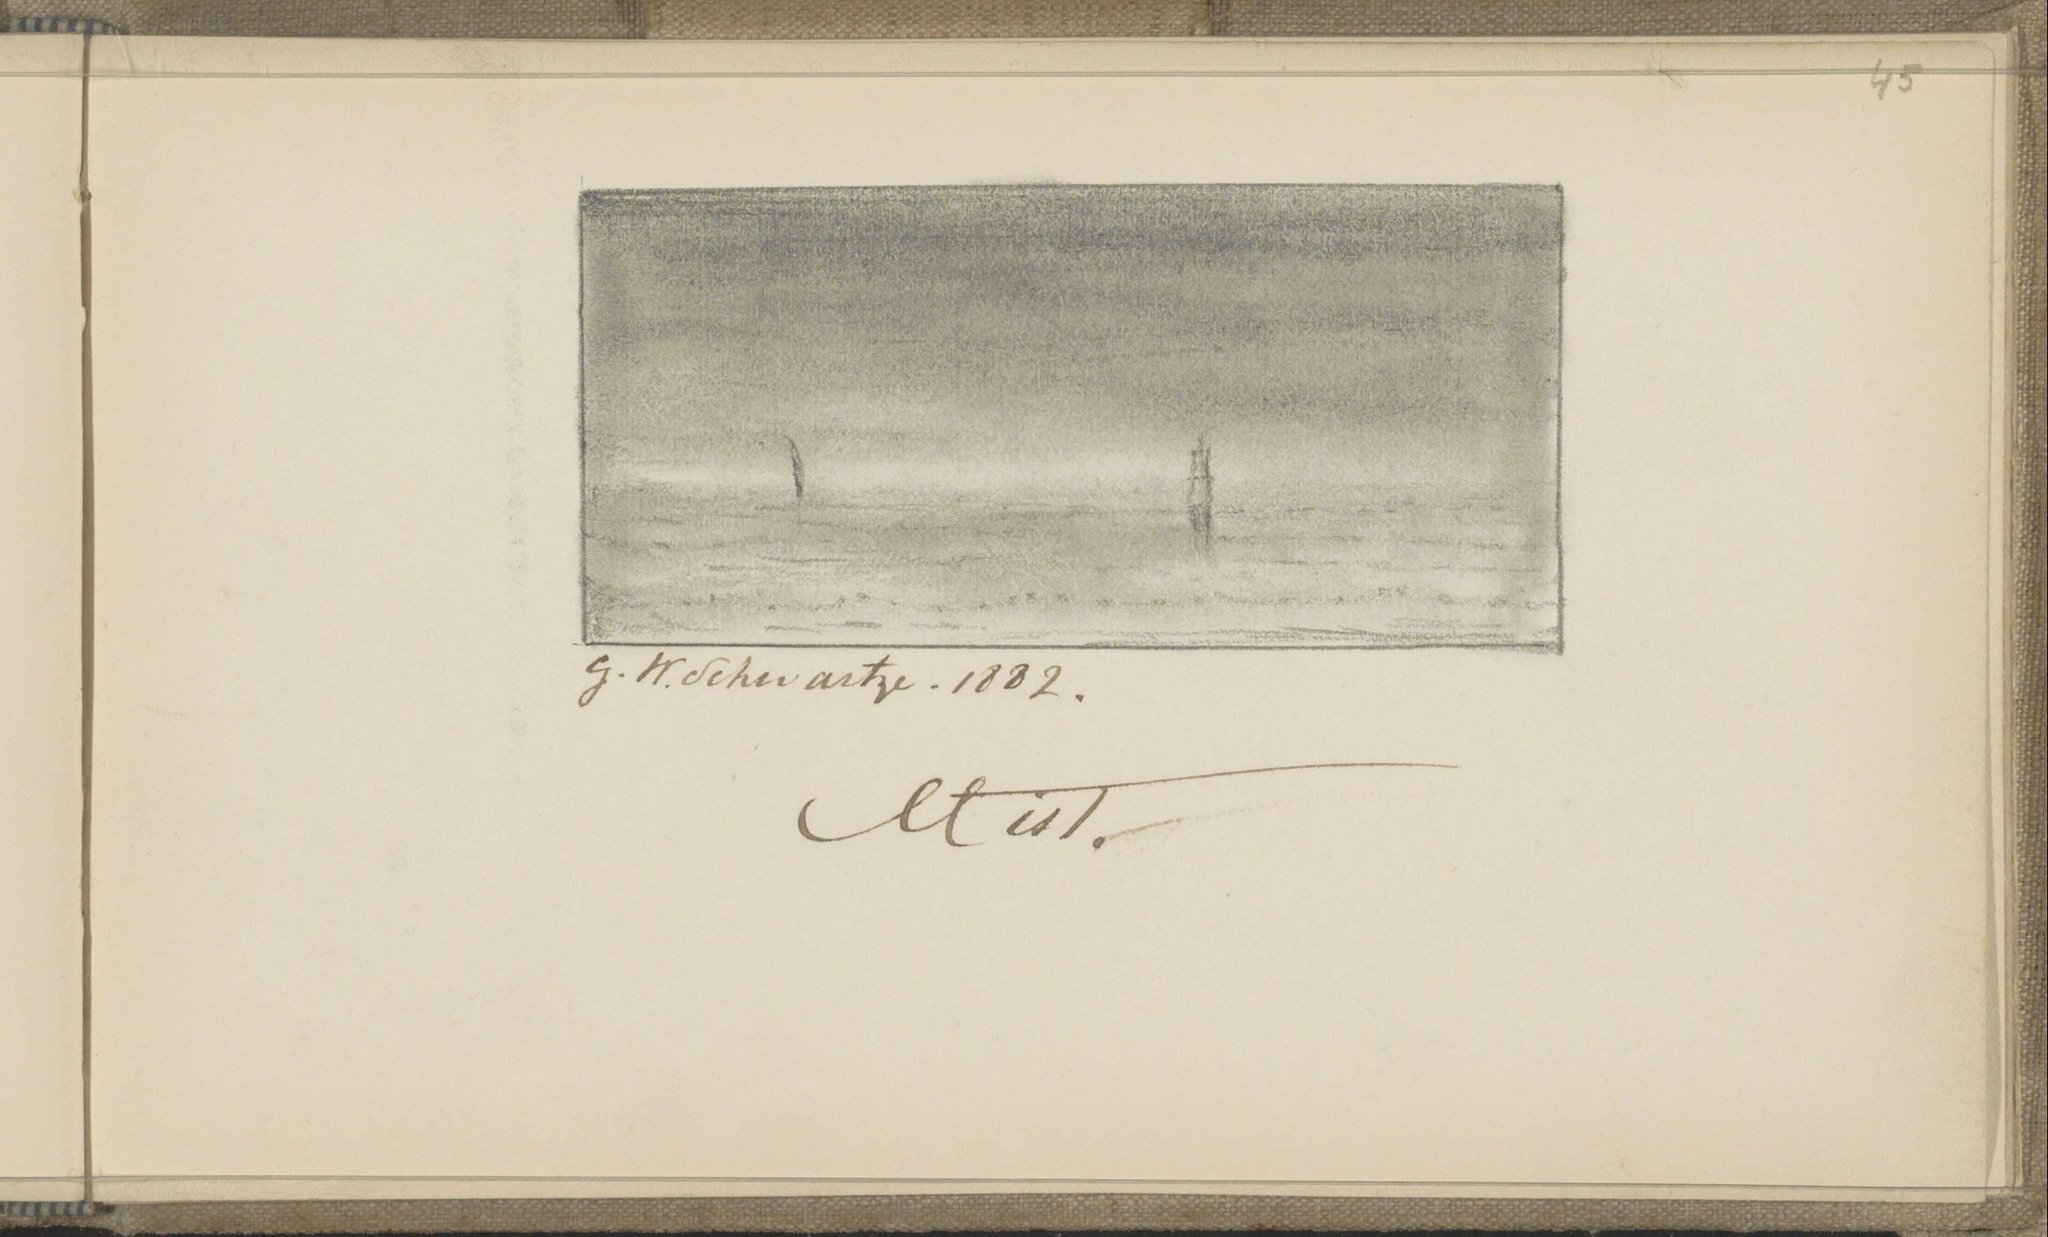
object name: sketchbook leaf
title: Zeemist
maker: george washington schwartze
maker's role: draughtsman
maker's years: 1857-1909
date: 1882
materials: paper, pencil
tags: sea (seascape), mist, fog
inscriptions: title: ‘Mist.’, signature and date: ‘G.W. Schwartze. 1882.’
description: Tekening in een kader. Blad 45 recto uit een schetsboek met 54 bladen.